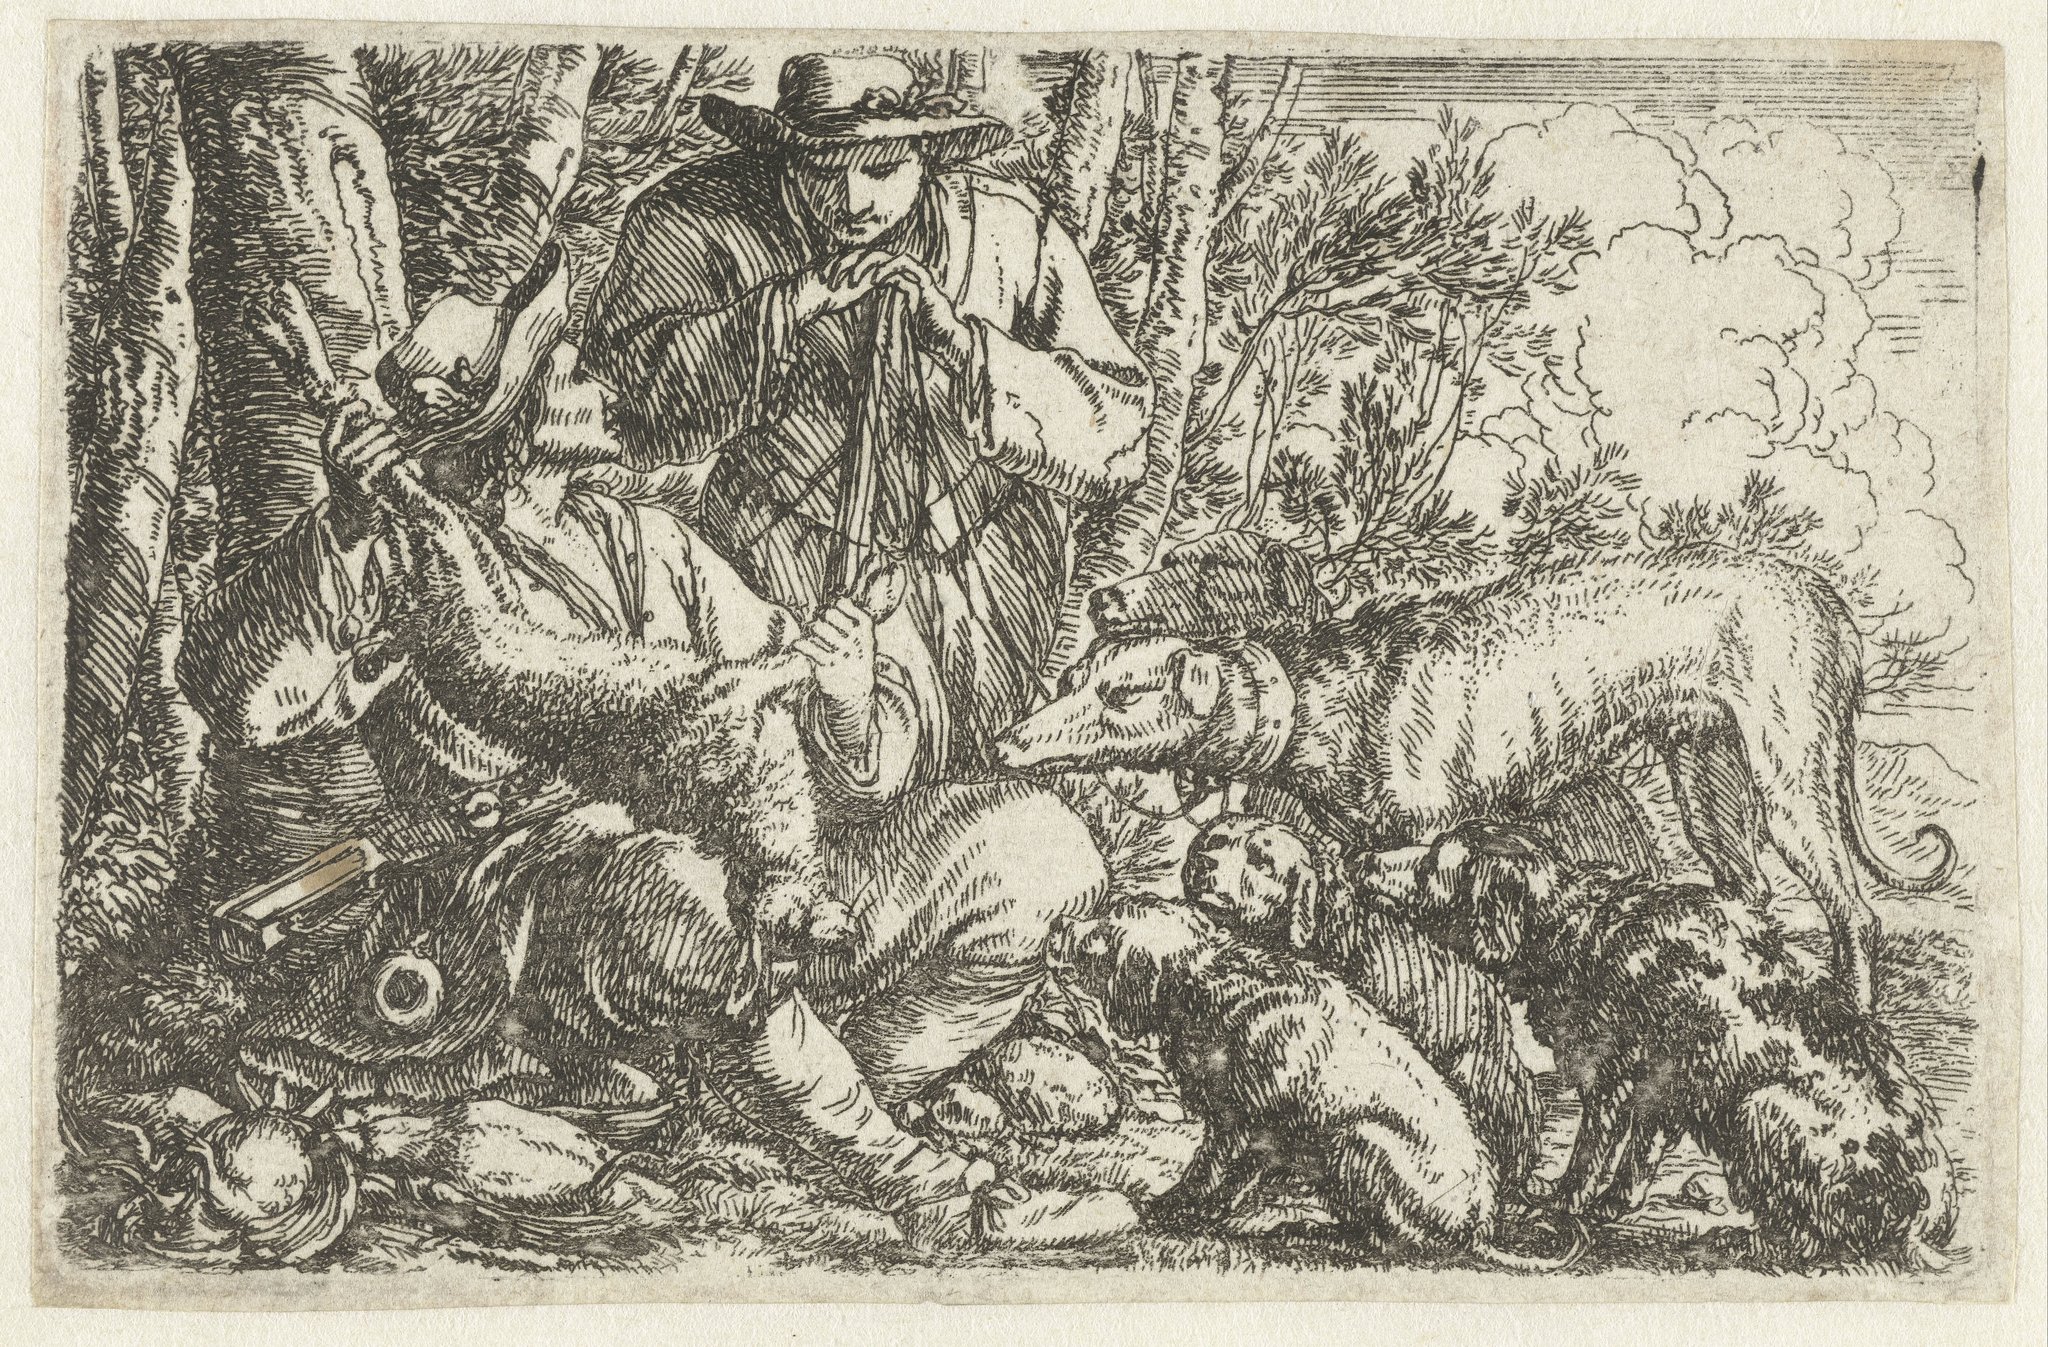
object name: print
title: Twee rustende jagers met hun honden en buit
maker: jonas umbach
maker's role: print maker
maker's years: 1624-1693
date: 1634-1693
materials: paper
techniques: etching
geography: augsburg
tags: hunting dogs, hunter, game, hunted animals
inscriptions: collector's mark: Lugt 240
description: Twee jagers bij een bosrand, één leunend op zijn geweer, de ander zittend tegen een boom met een dode haas in zijn handen. Vijf honden zitten tegenover hem, met de blik gericht op het geschoten wild.